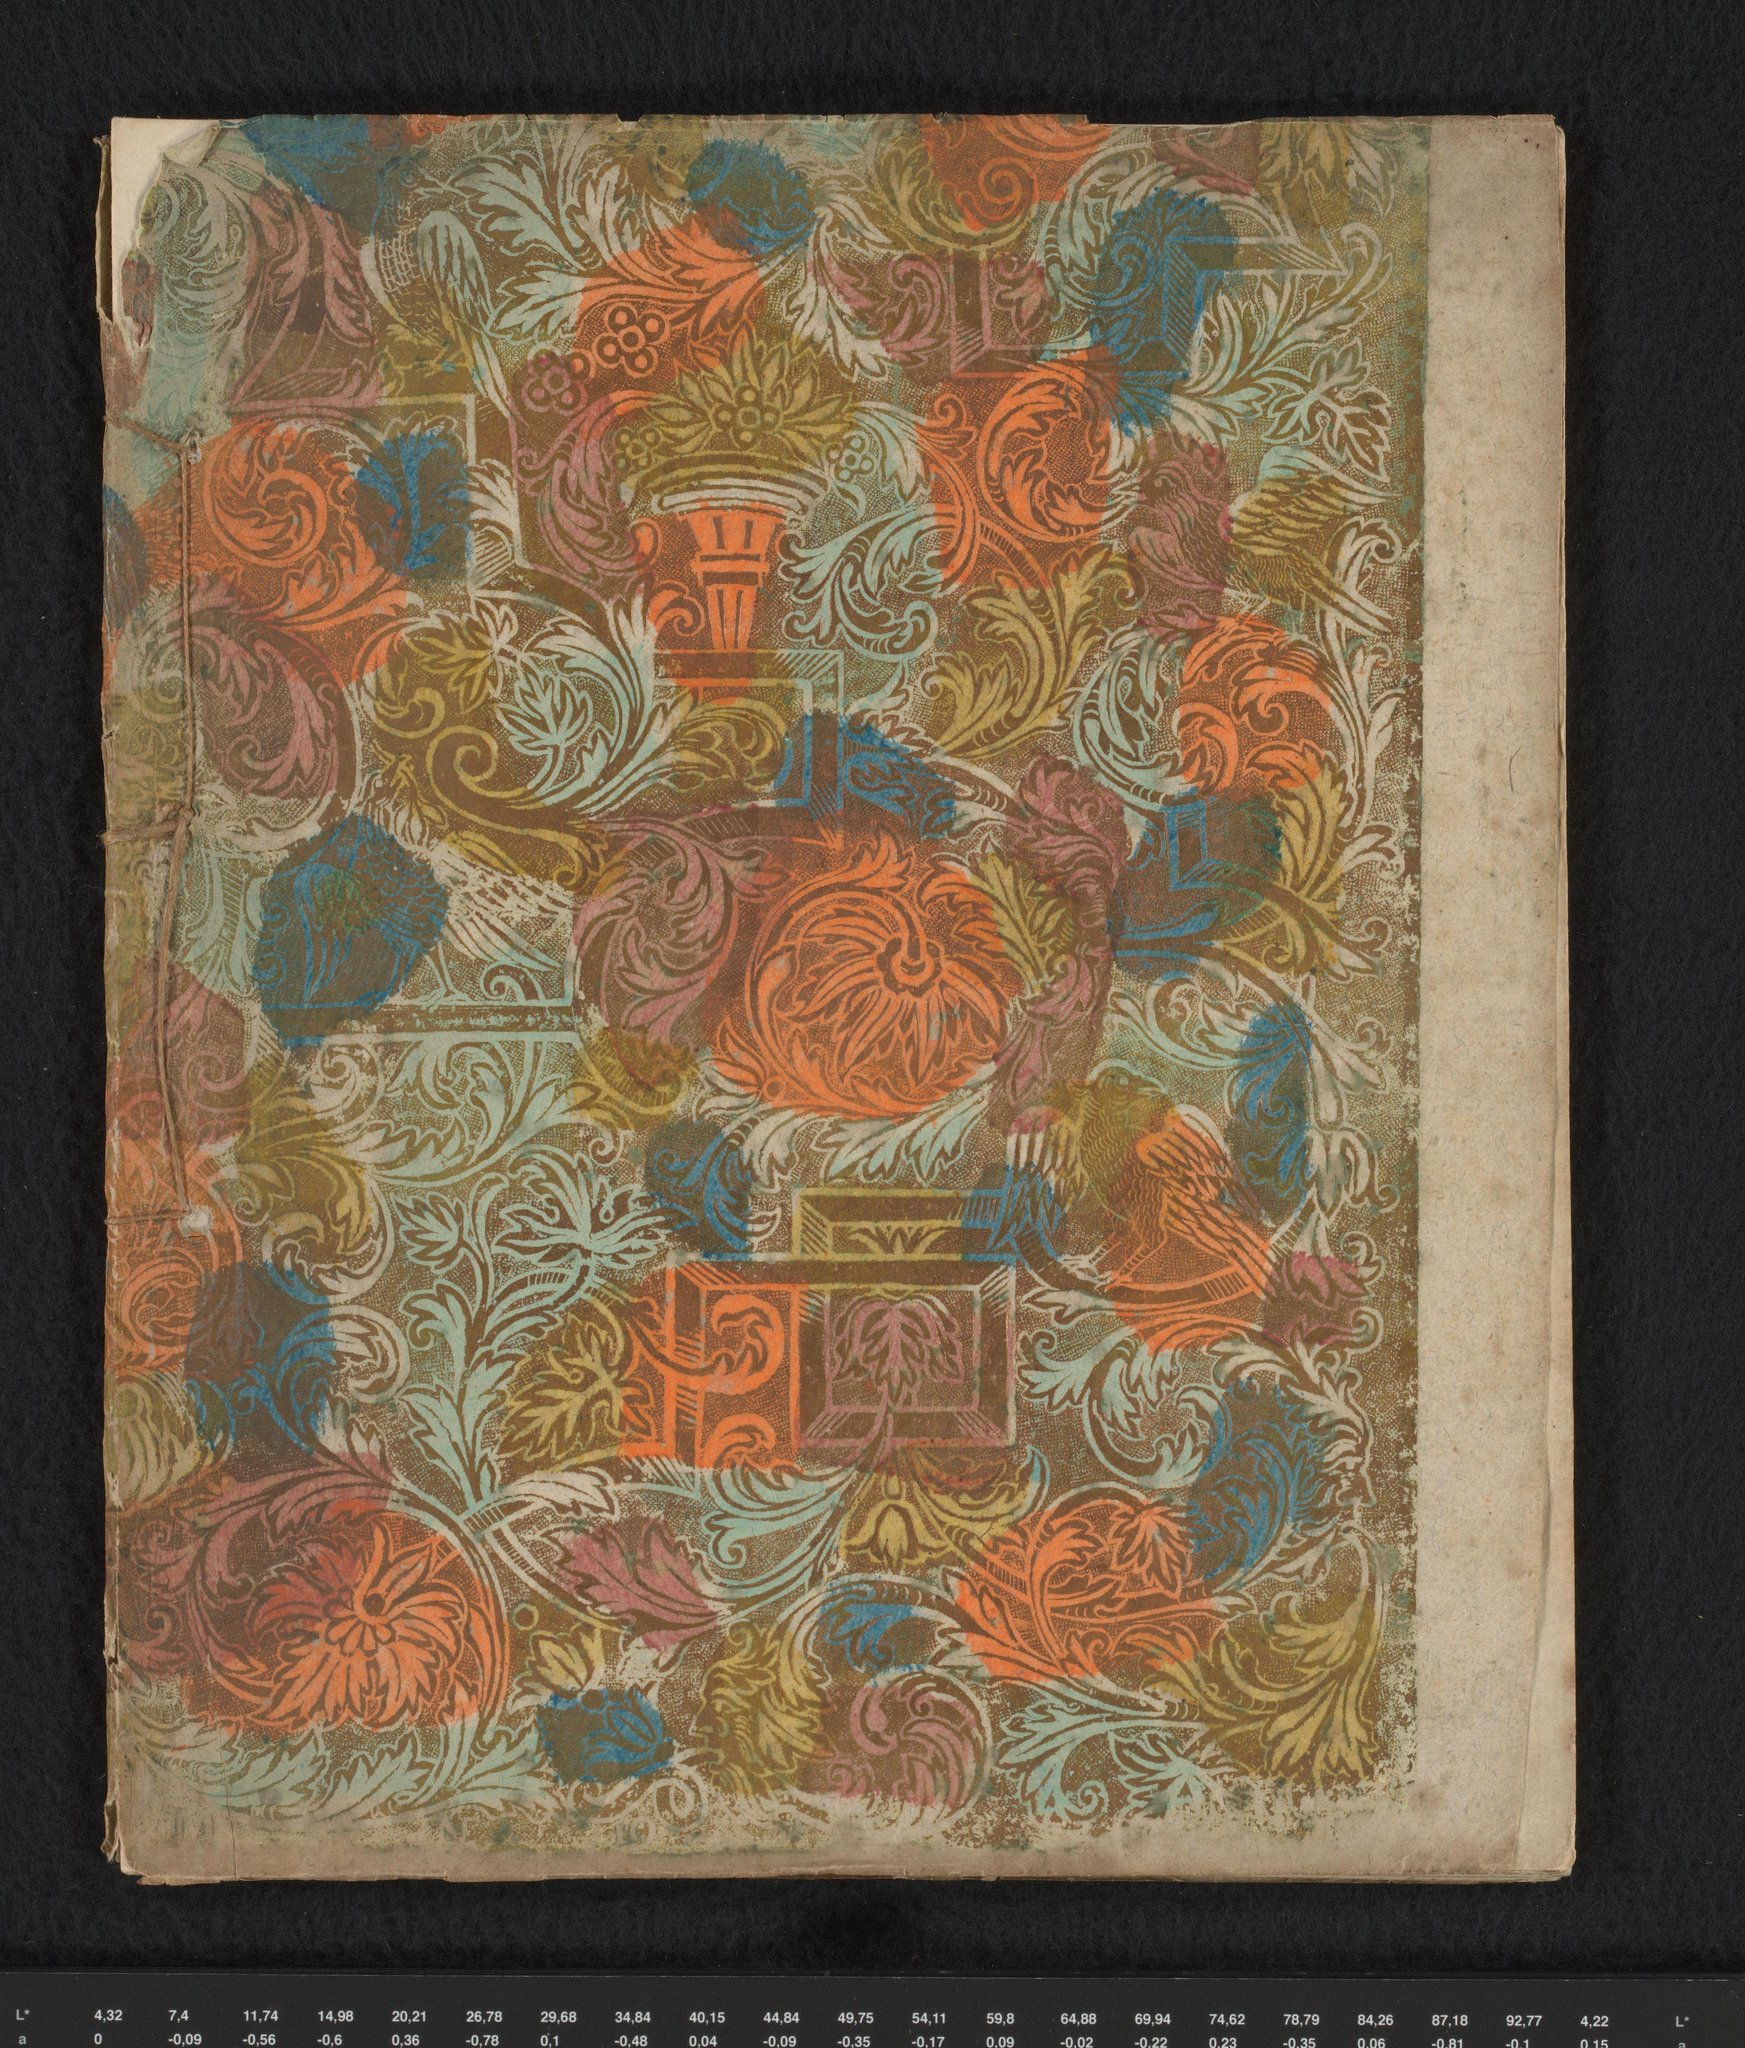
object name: brocade paper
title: Specimen antiquario-juridicum inaugurale, sistens Animadversiones quasdam criticas ad Diplomata quaedam a Mattheaeo edita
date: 1788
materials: gold leaf, paint, paper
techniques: letterpress printing, relief print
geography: utrecht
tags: utrecht, johan gerard swellengrebel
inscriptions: name: ‘IM N 19’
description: Specimen antiquario-juridicum inaugurale, sistens Animadversiones quasdam criticas ad Diplomata quaedam a Mattheaeo edita. Proefschrift van Johan Gerard Swellengrebel, Universiteit Utrecht 1788. In omslag van goudbrokaatpapier met bloemen, ranken en vogels. (gemerkt onderaan: IM N 19).